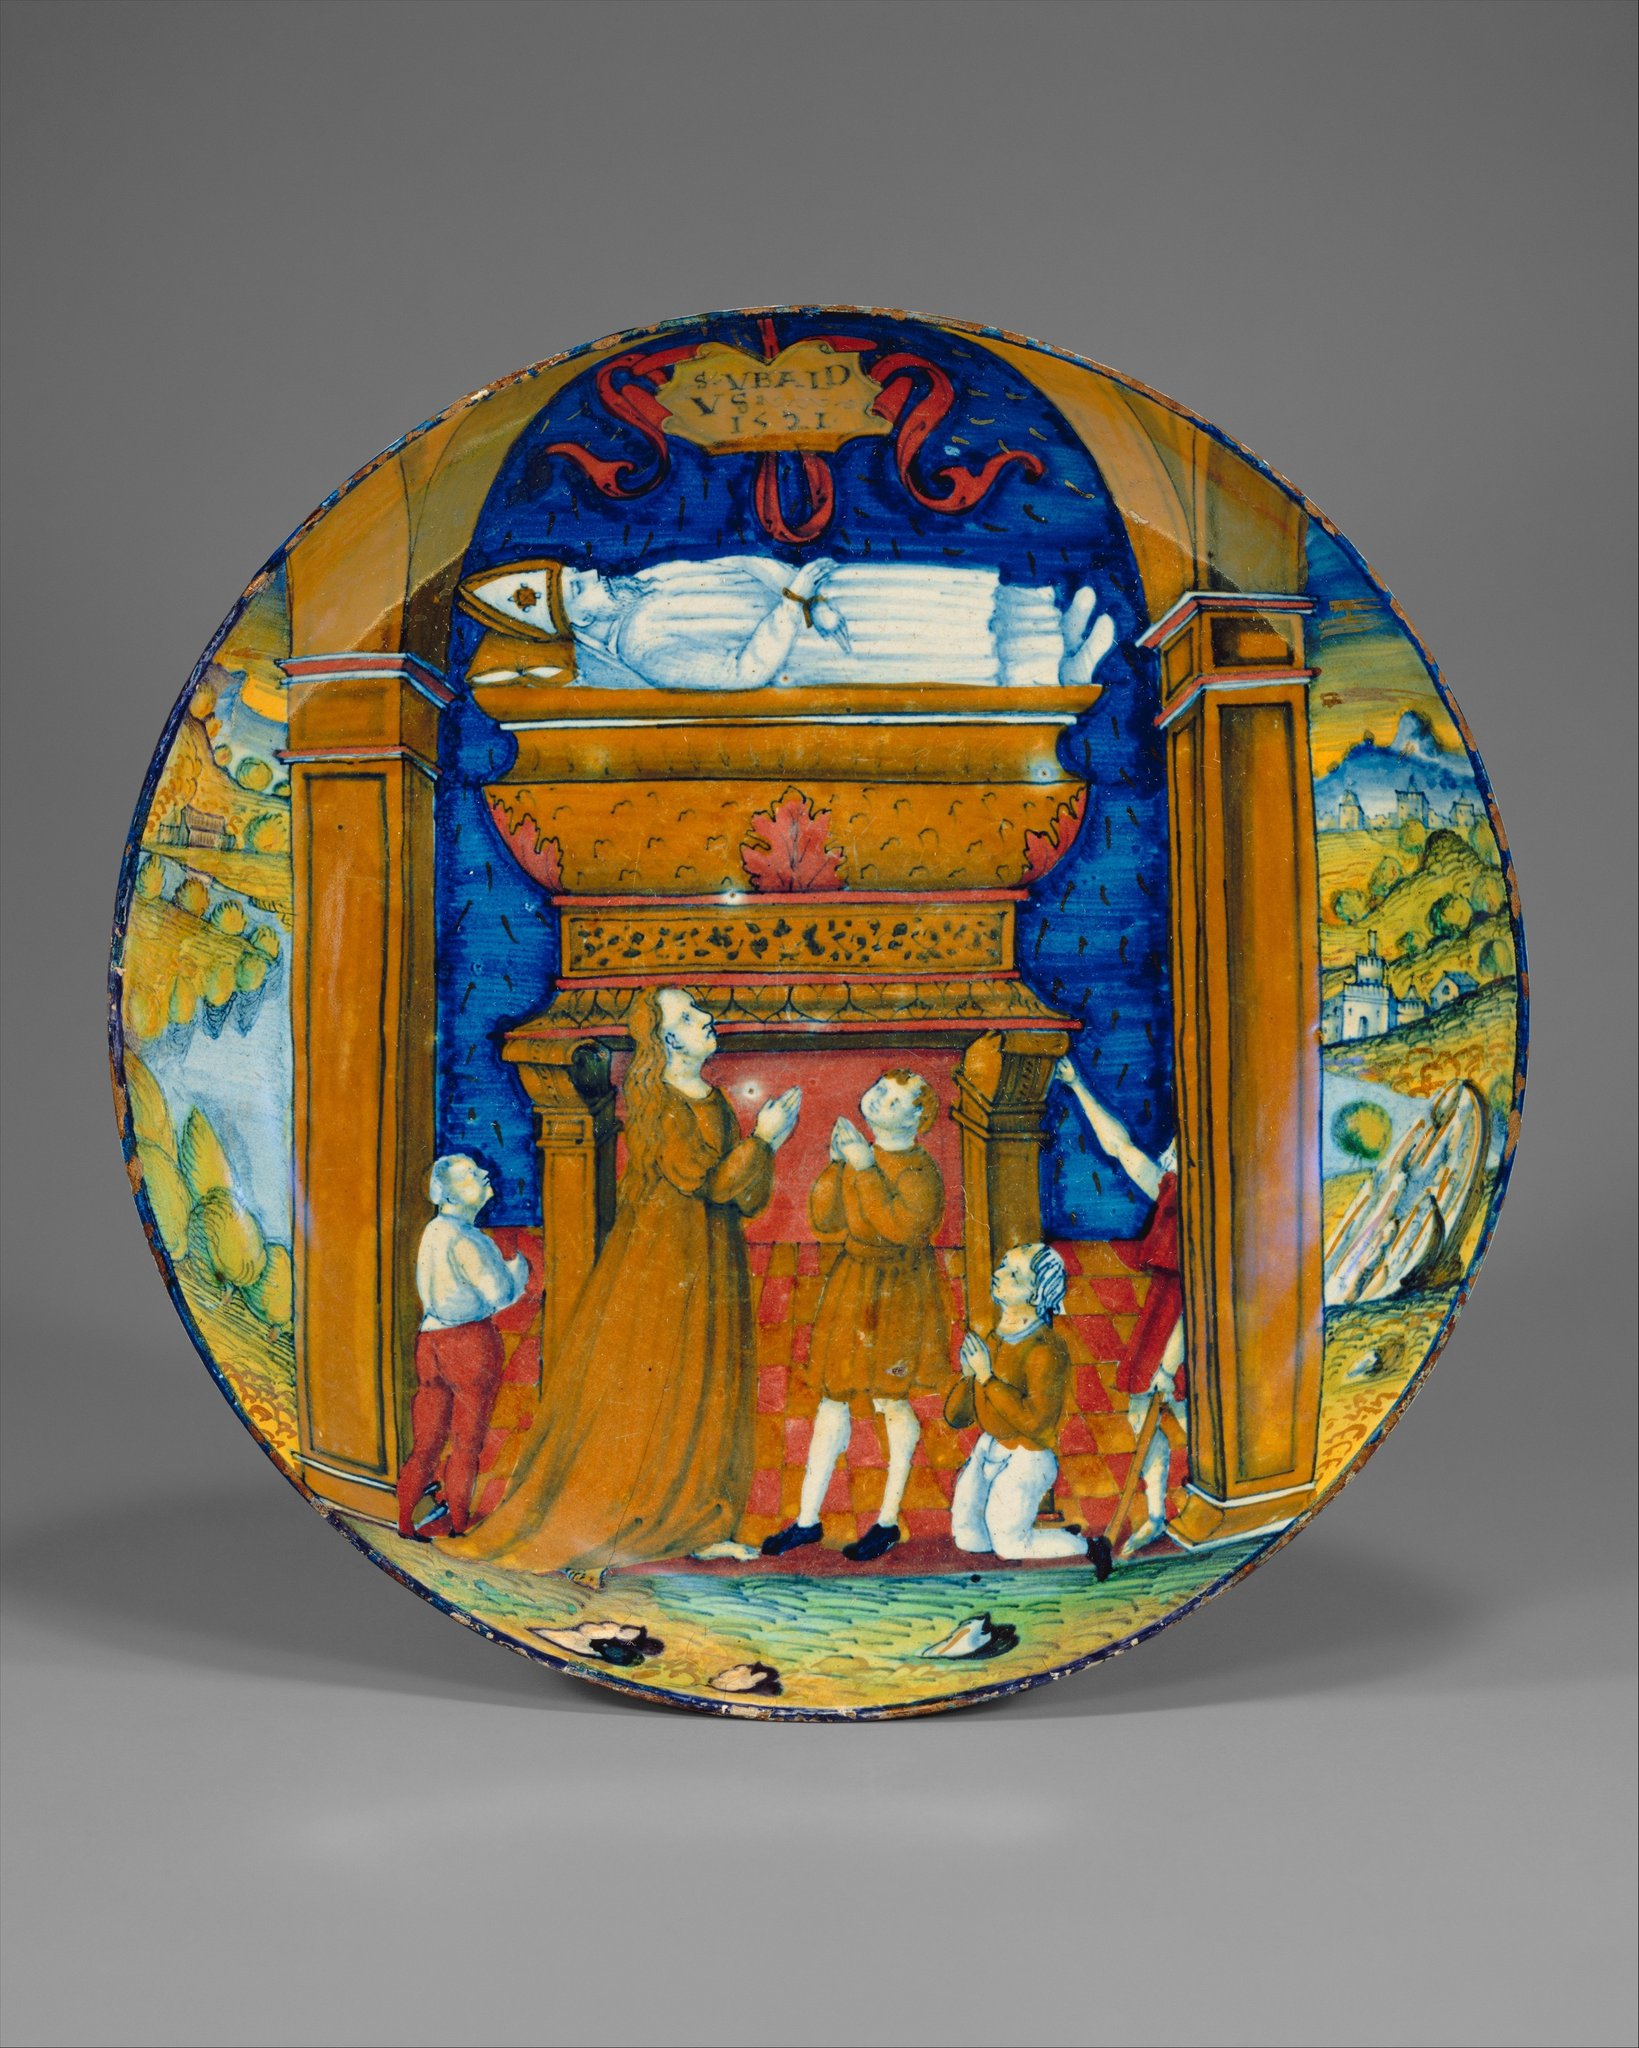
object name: dish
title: Dish (coppa)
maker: the saint ubaldus painter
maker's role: artist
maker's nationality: italian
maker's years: 1500-1550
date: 1521-1522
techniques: maiolica, glazing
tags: tombs,men,women,death